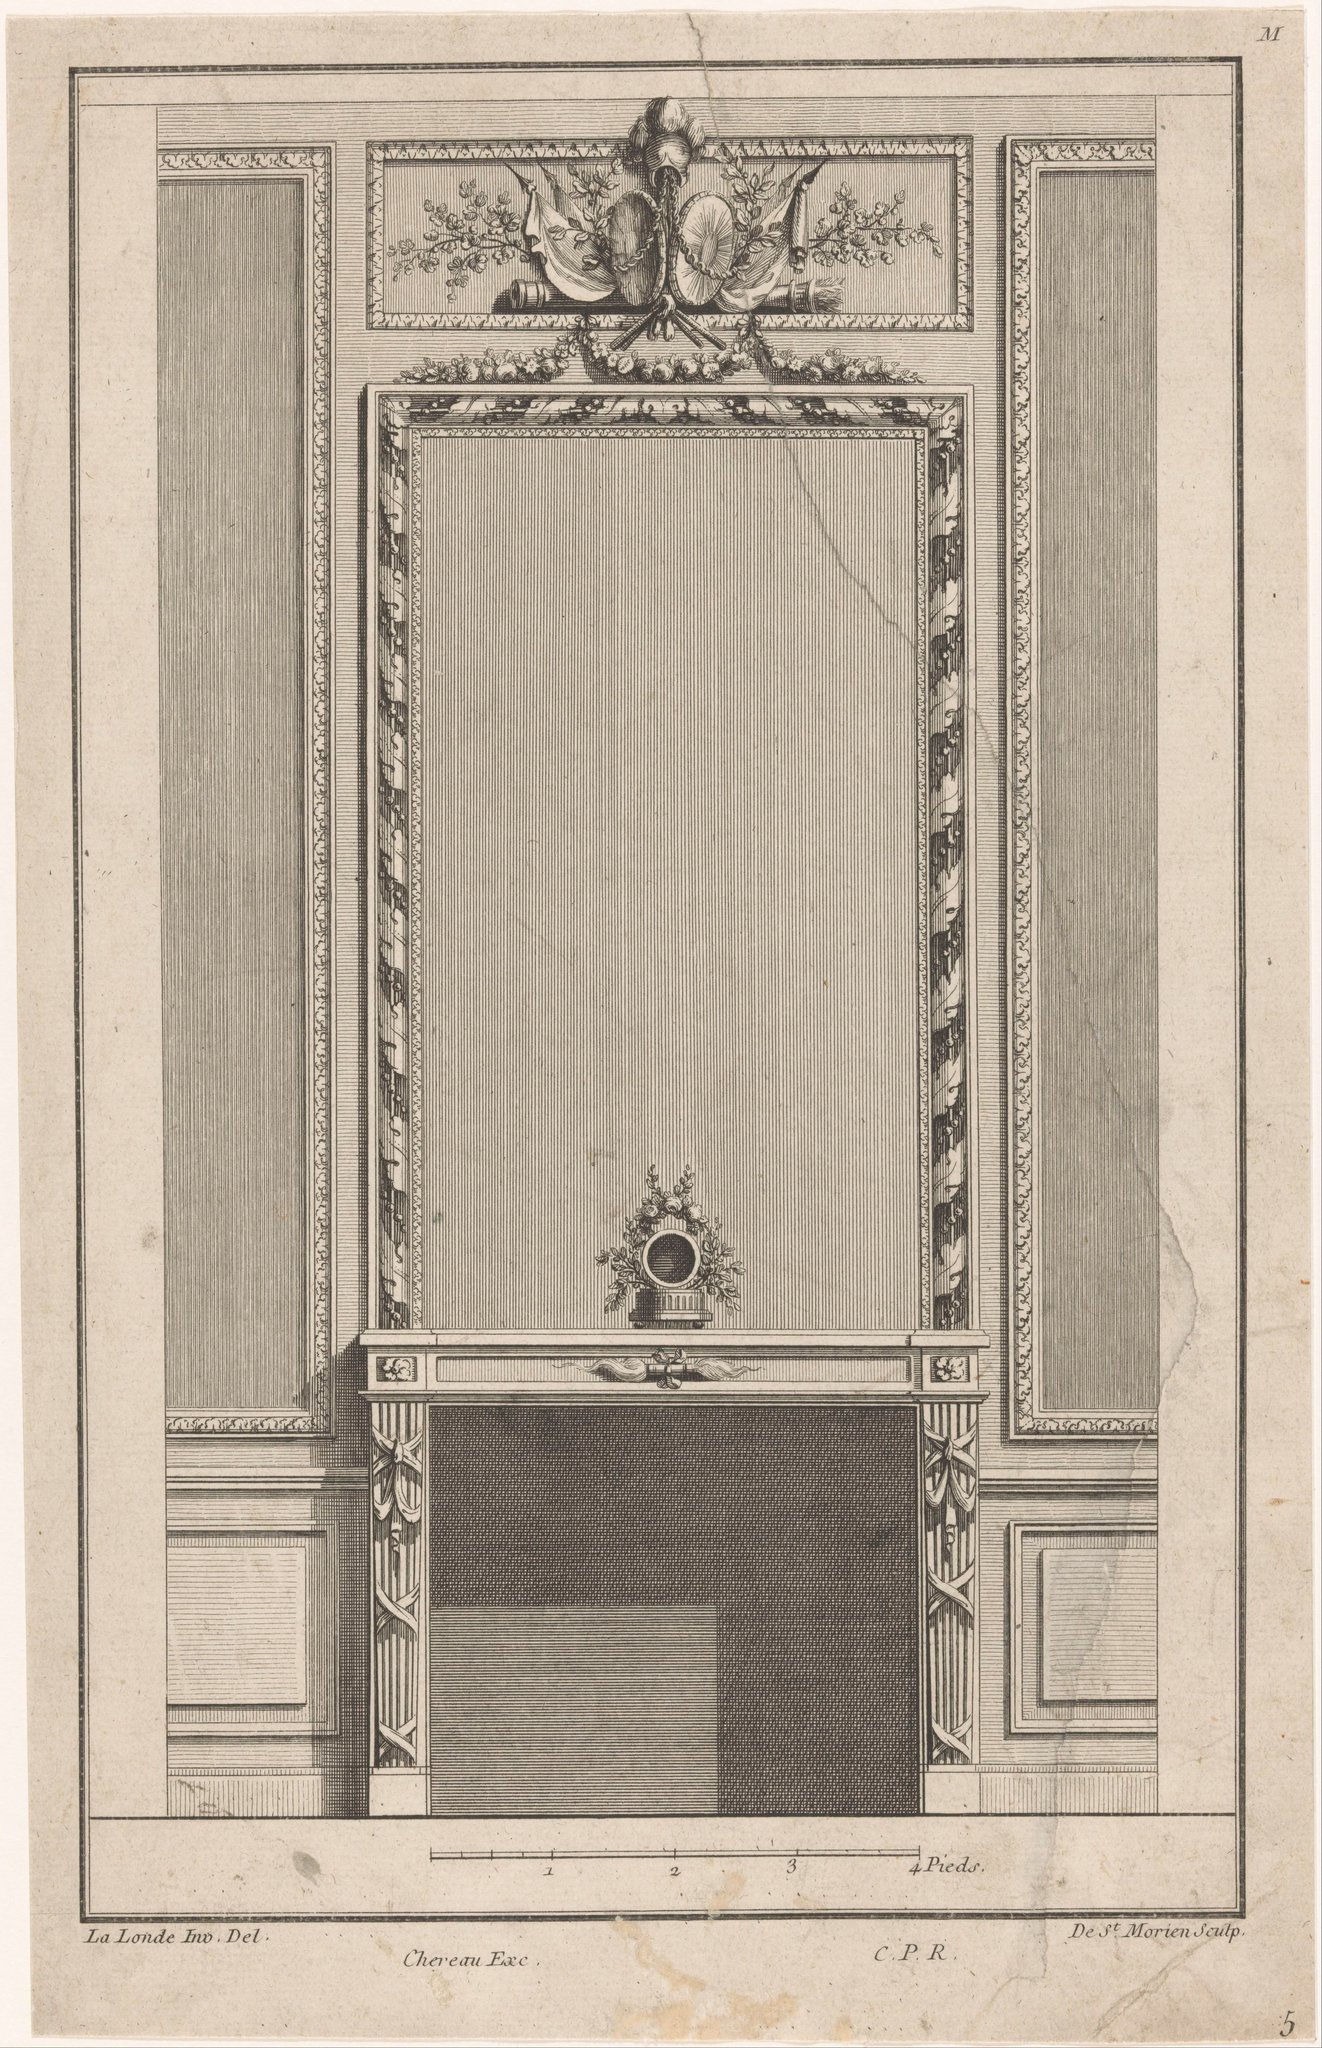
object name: print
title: XIIe Cahier de l'Oeuvre M Cheminées avec leurs Trumeaux &c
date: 1784-1785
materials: paper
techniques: engraving, etching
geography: paris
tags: 'tropaion', i.e. decorative ornament ~ weapons, open hearth, fire-place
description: Een geornamenteerde schouw met een pendule en aan de bovenzijde een paneel met wapentrofee.